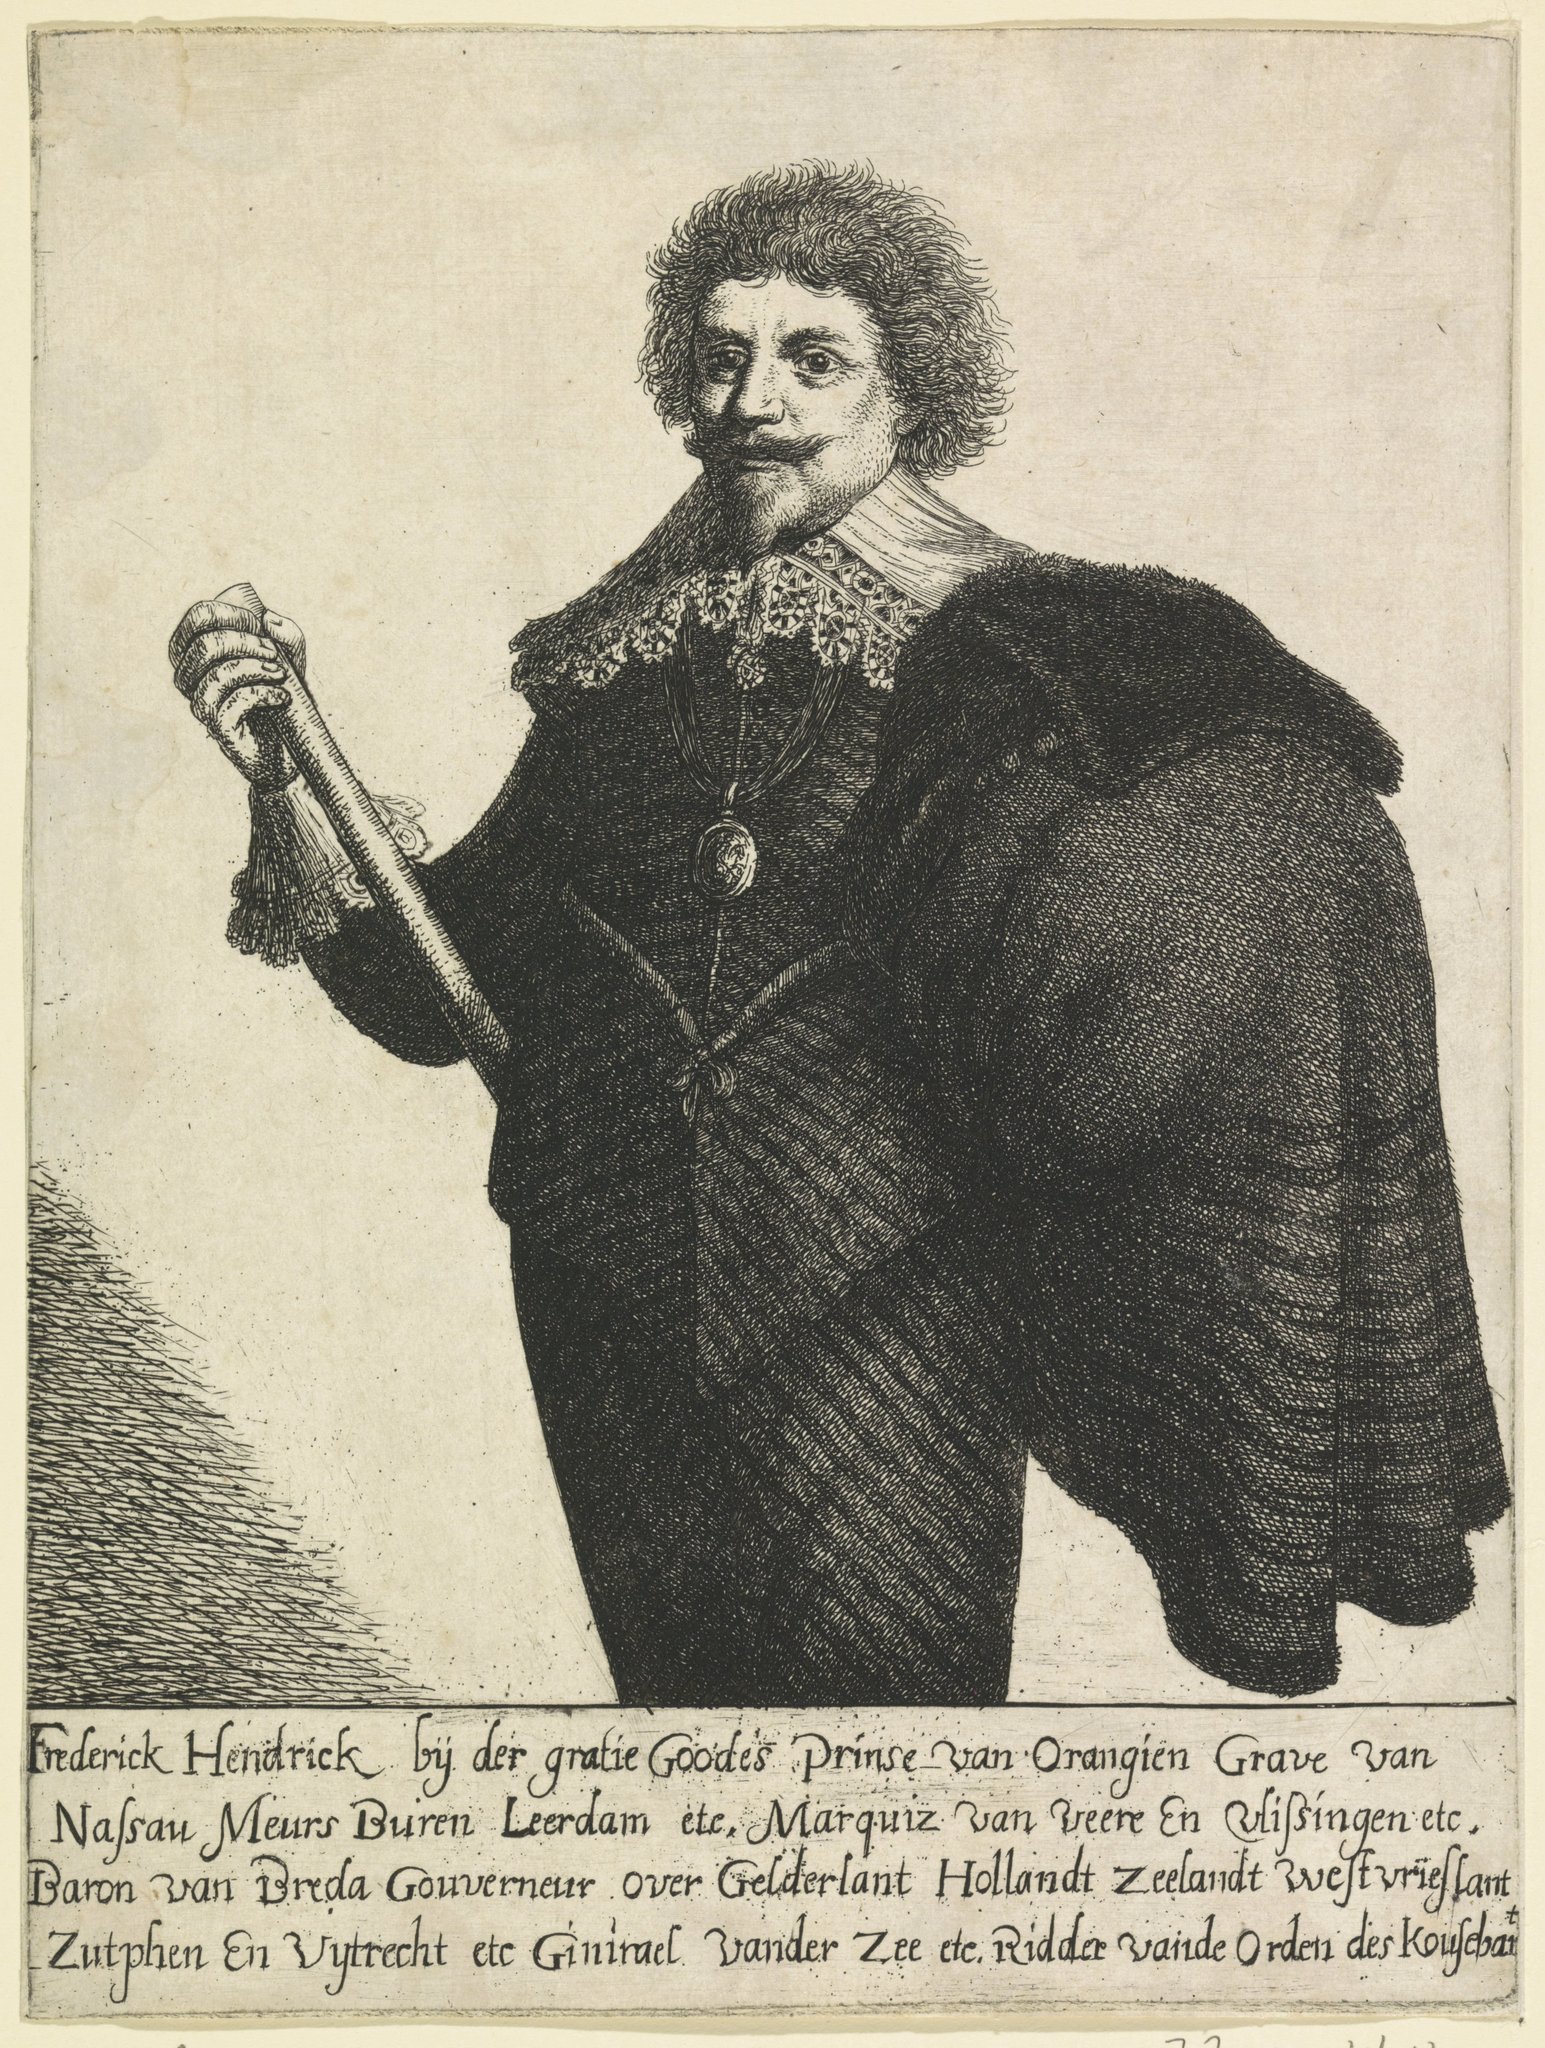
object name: print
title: Portret van Frederik Hendrik, prins van Oranje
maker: jan gillisz. van vliet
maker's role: draughtsman, painter, print maker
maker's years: 1600-1668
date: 1628-1637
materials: paper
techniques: etching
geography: low countries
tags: delft, the hague, frederick henry (prince of orange), knighthood order (garter) - insignia of a knighthood order, e.g.: badge, chain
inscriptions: collector's mark: Lugt 2228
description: De hier vermelde titel verwijst naar de hoogst verkregen titel van de geportretteerde, niet per se naar de titel die de geportretteerde op deze voorstelling draagt.